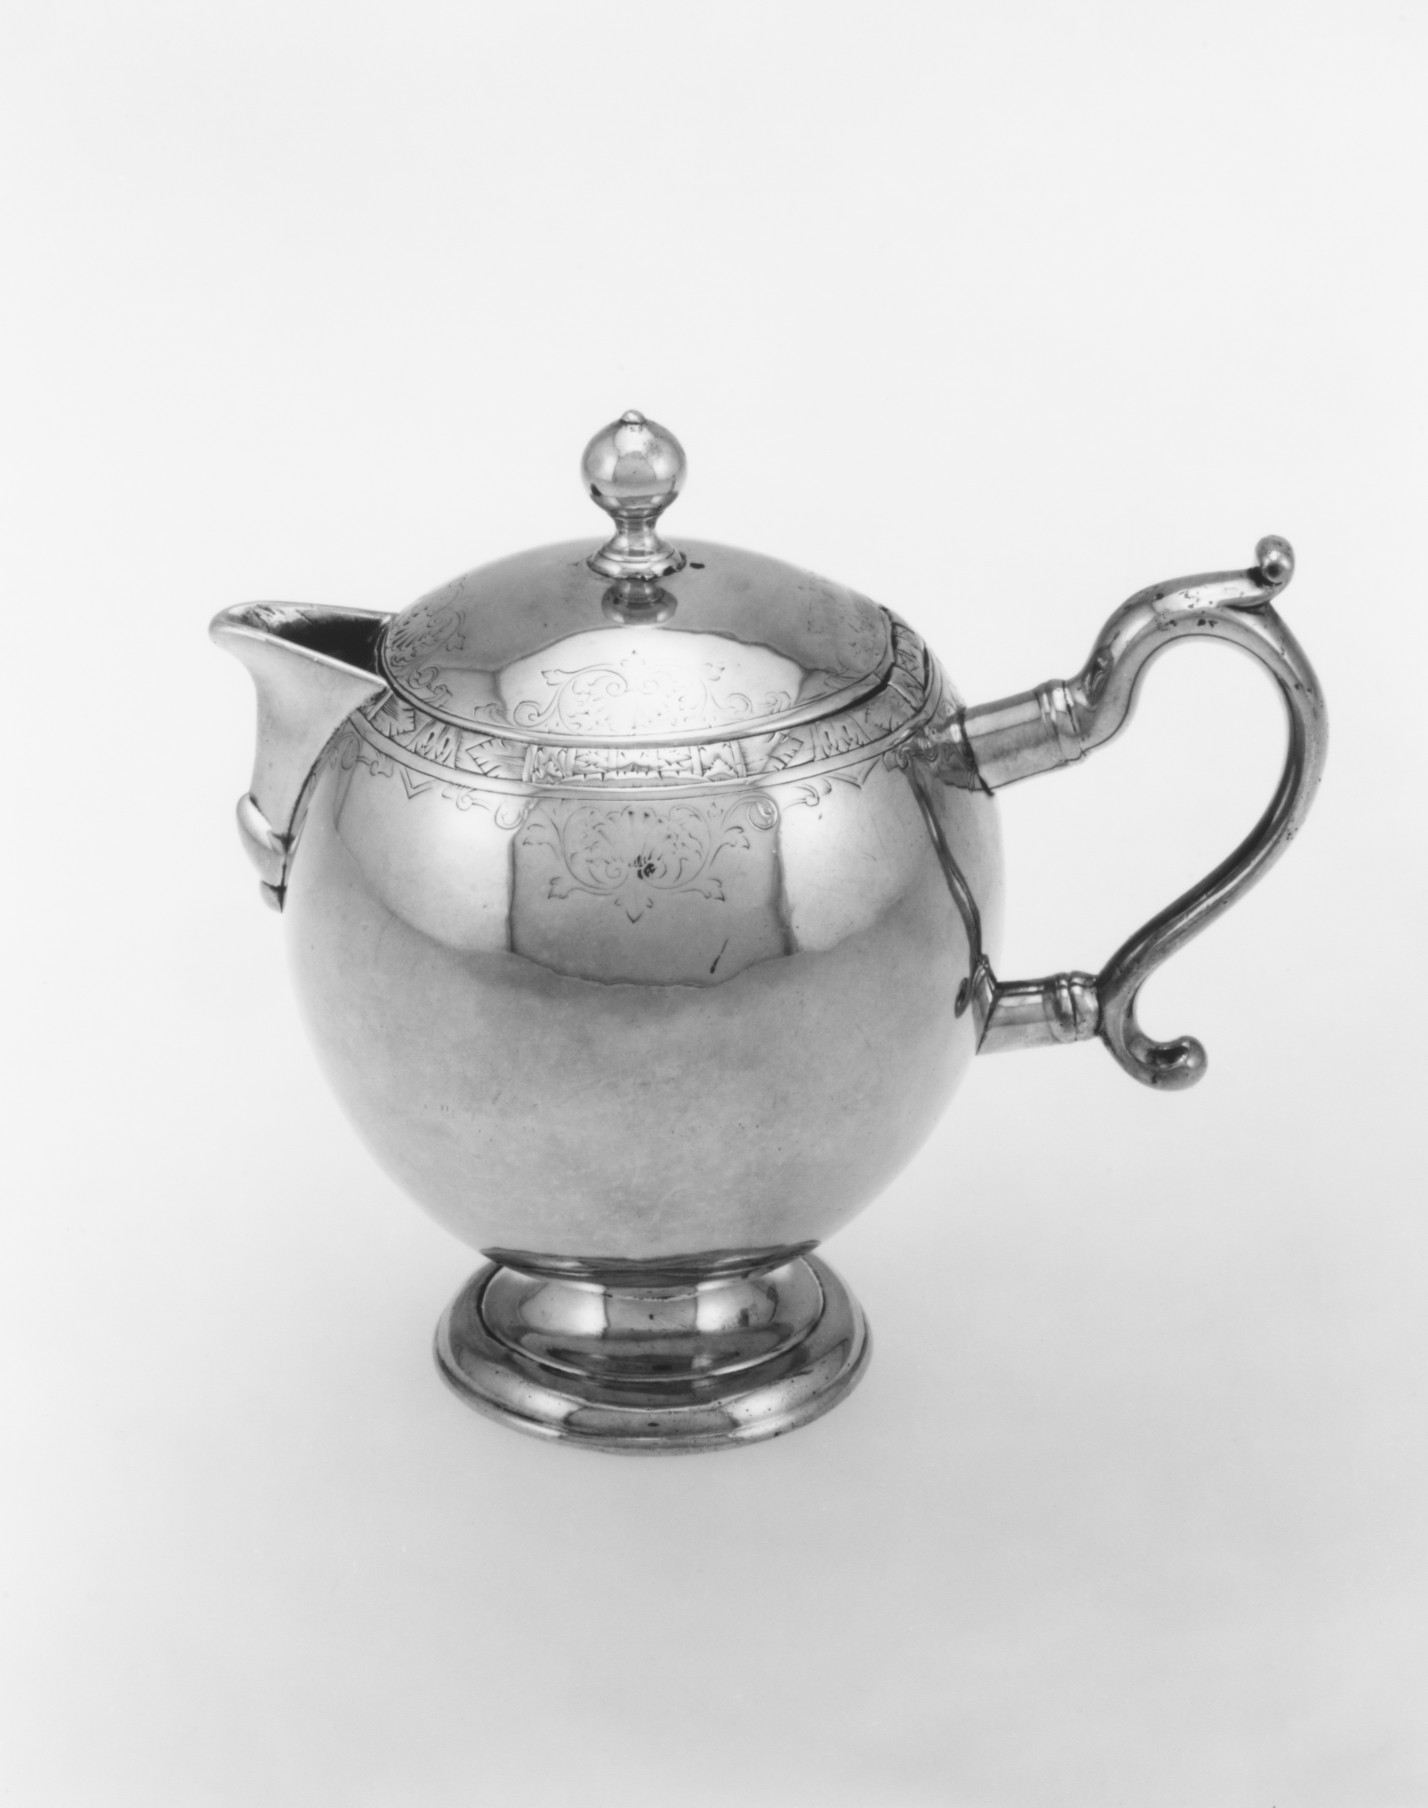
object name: hot milk jug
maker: james ker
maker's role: maker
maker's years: 1675-1775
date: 1727-1728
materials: silver